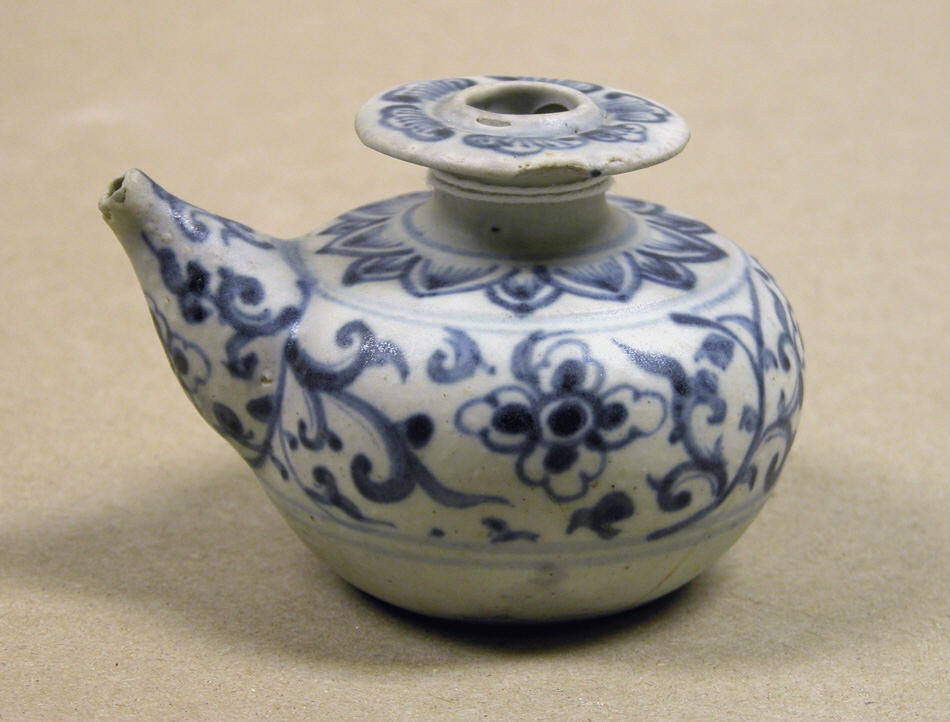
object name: kendi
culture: vietnamese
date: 1401-1600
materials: cobalt, stoneware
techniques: underglaze